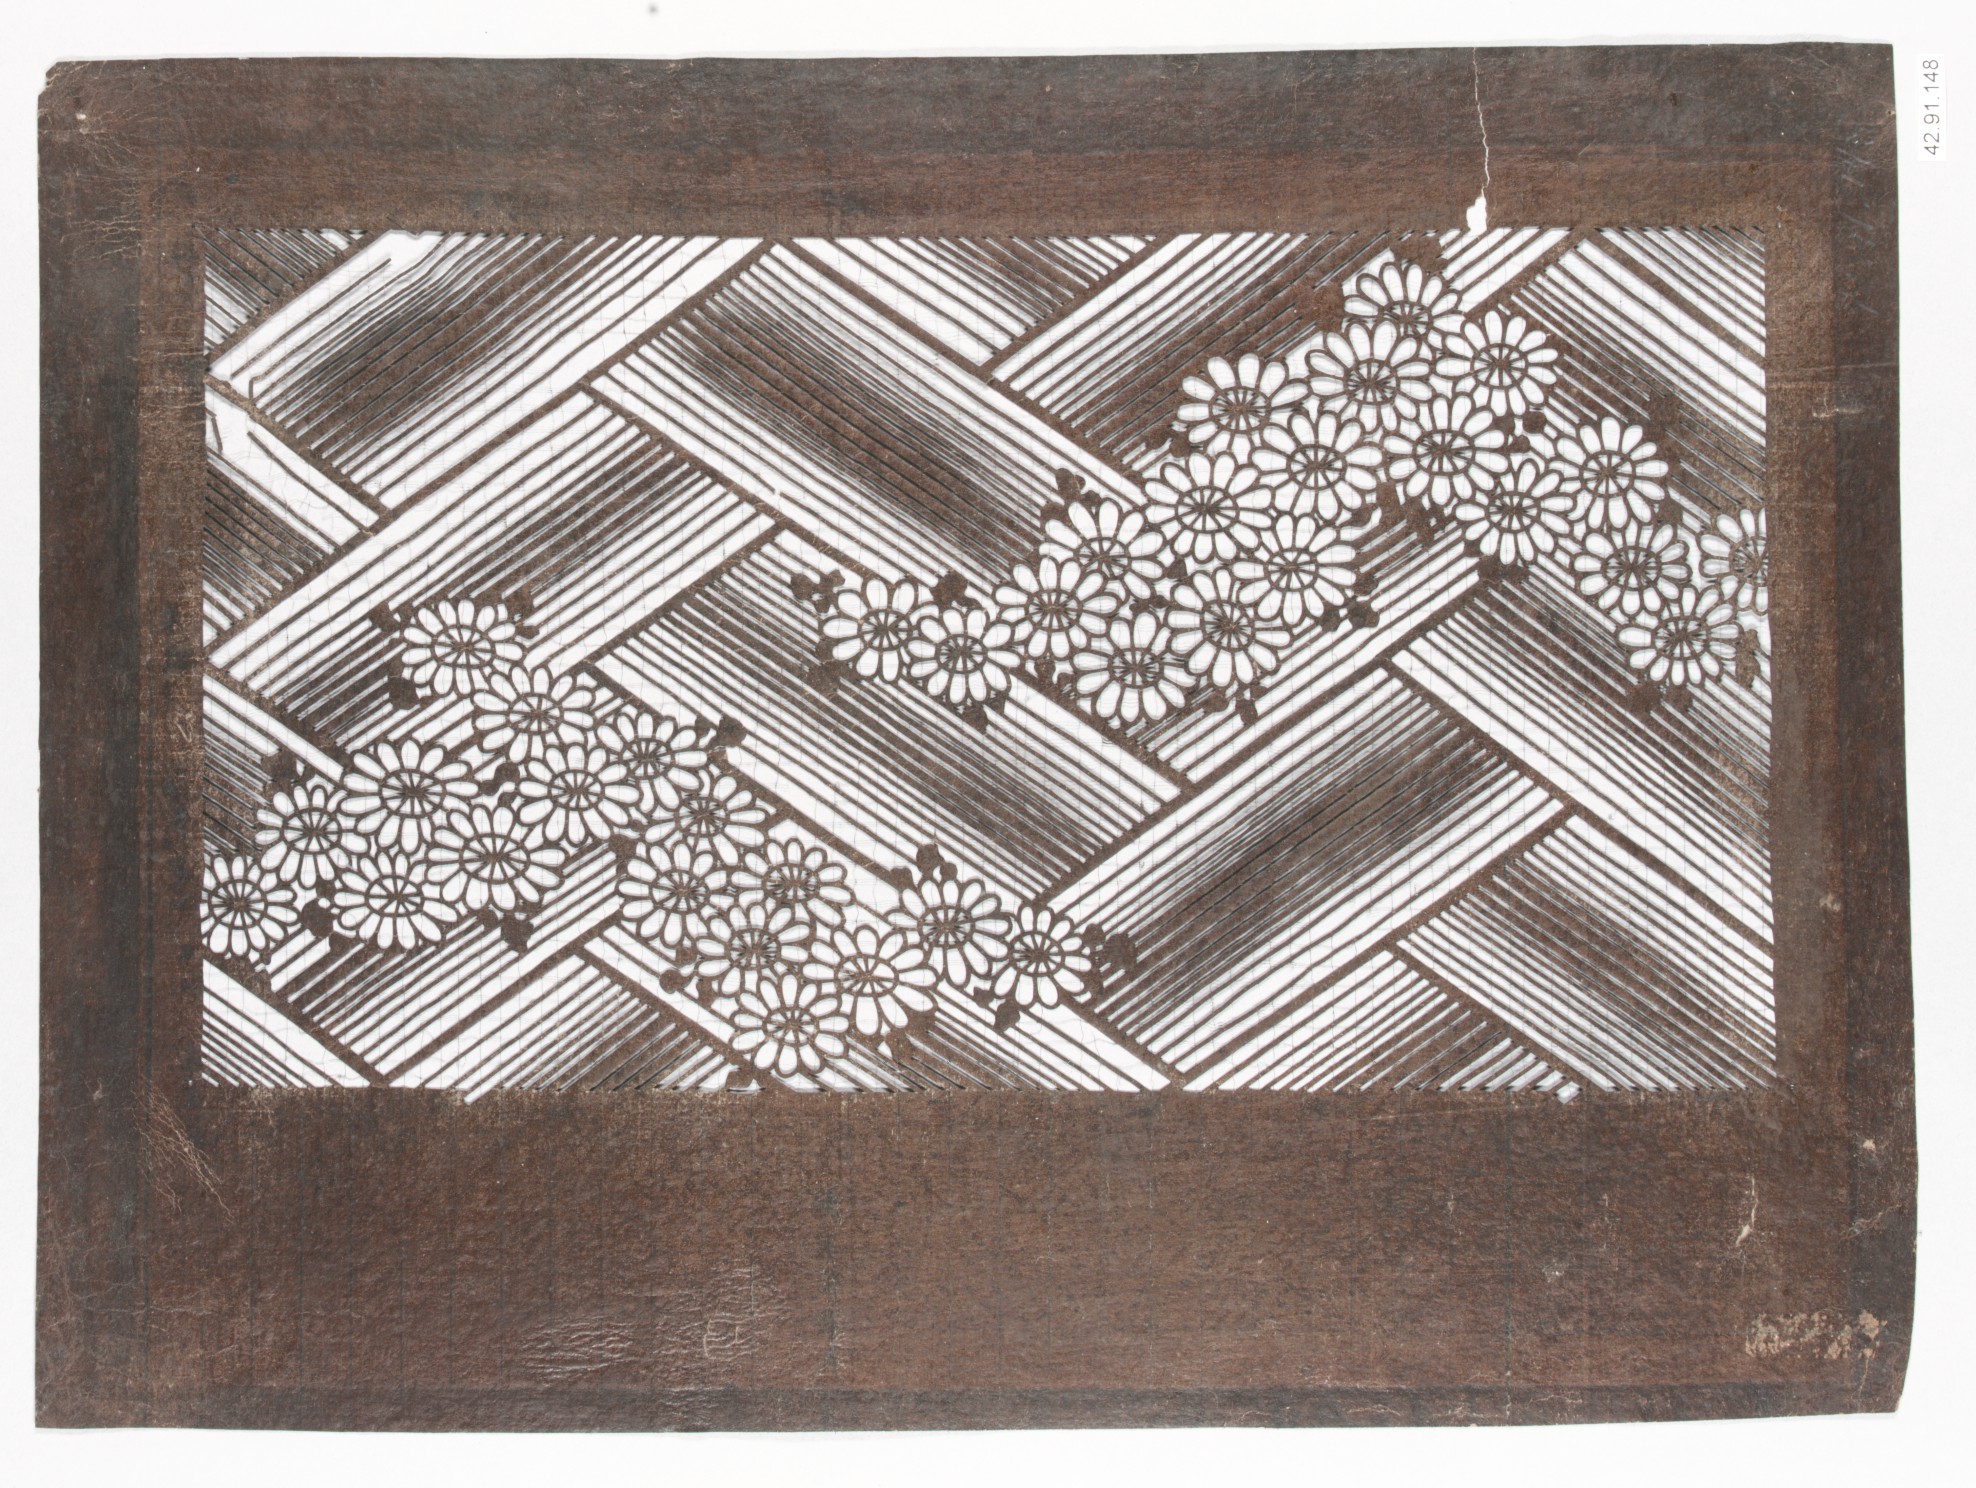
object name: stencil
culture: japanese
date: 1801-1900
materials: paper, silk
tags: flowers